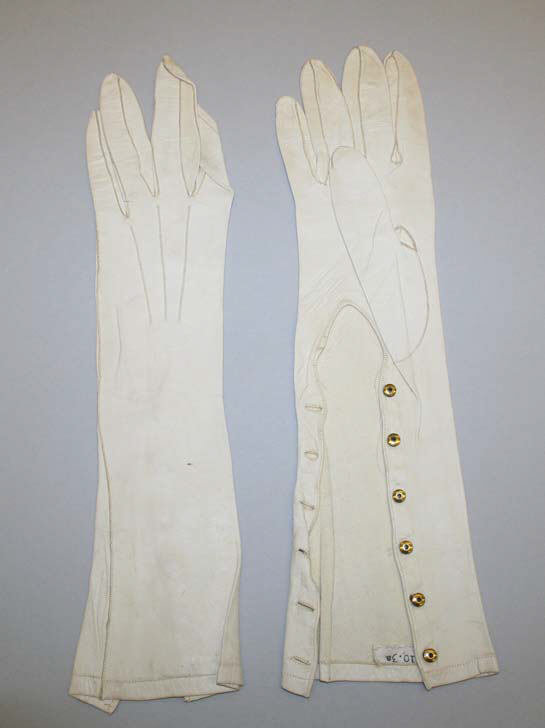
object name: glove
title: Gloves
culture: american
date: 1880-1889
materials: brass, leather